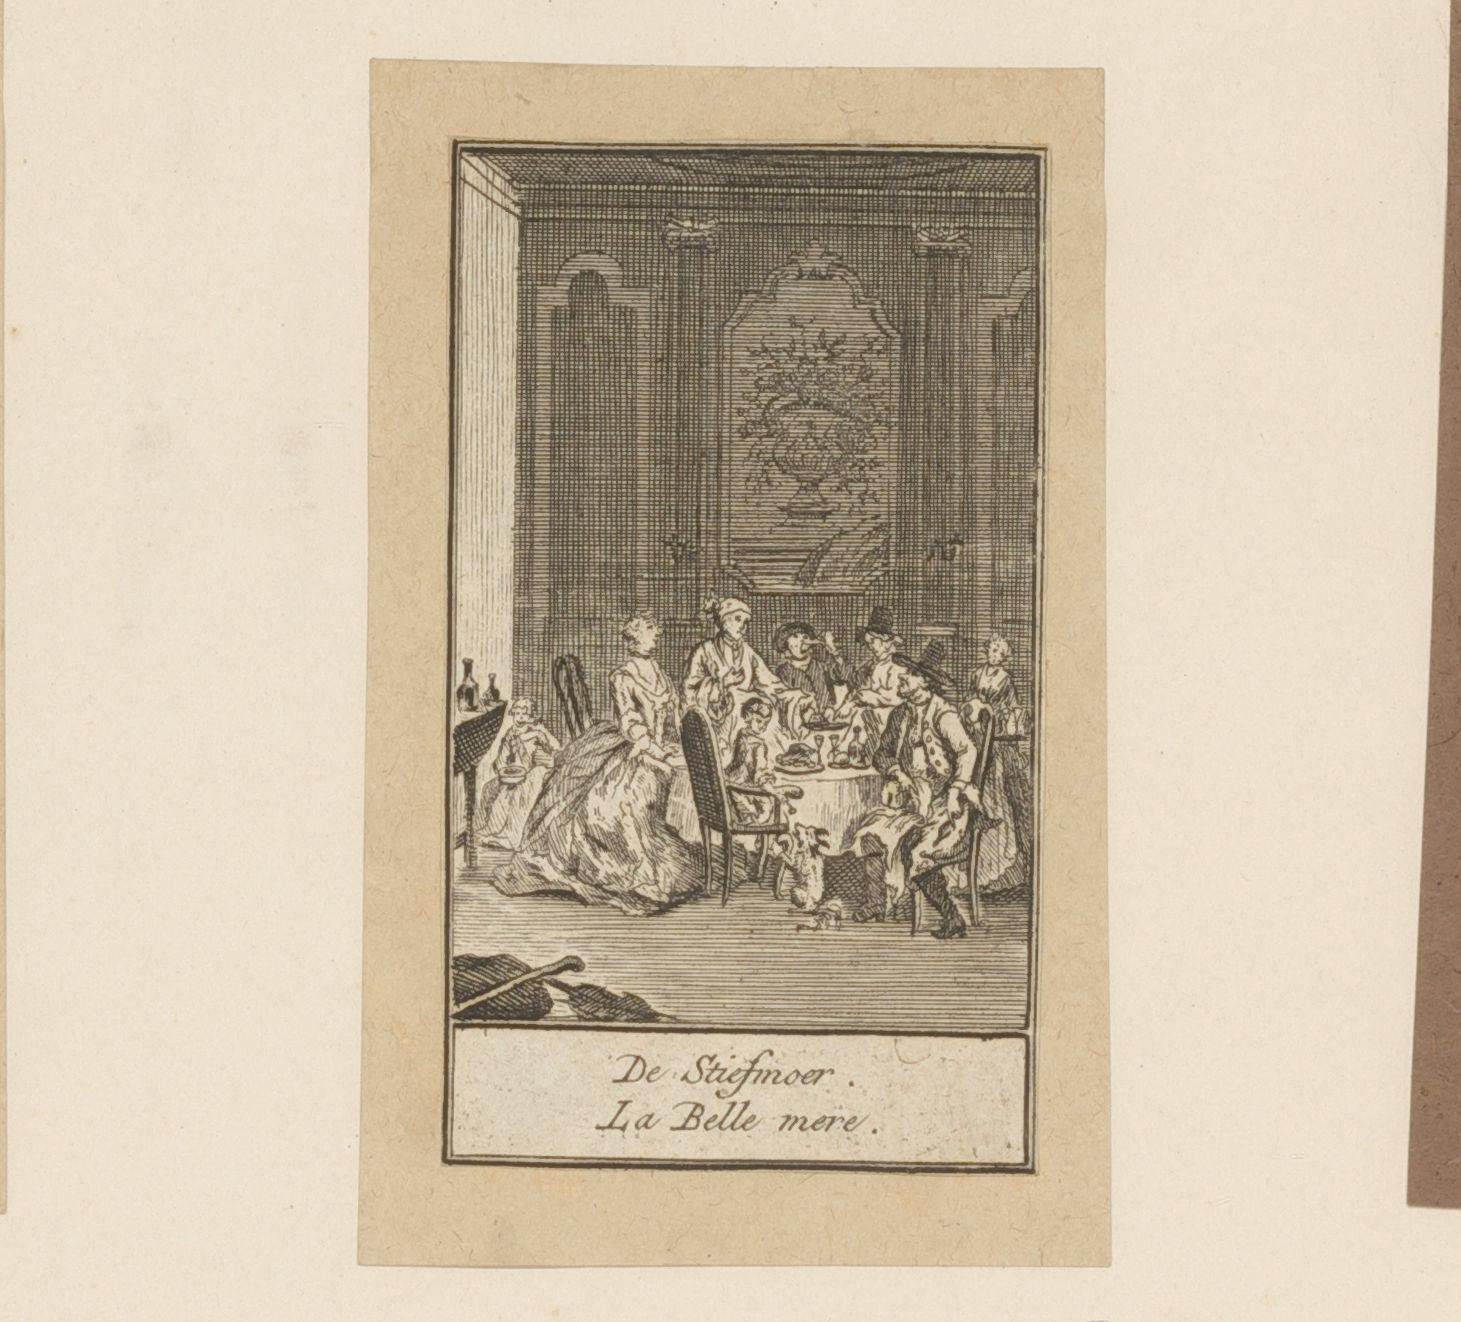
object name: print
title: De Stiefmoer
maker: Anonymous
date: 1760-1799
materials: paper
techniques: engraving, etching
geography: netherlands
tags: giving food, contrast between rich and poor, eating and drinking, dining-room, comedy, dog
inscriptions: collector's mark: Lugt 2488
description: Een eetkamer met figuren rond een tafel waaraan een staande heer een bord reikt aan zijn gasten. Rechts een rijk aangeklede vrouw en kind. Tegenover hen drie sober geklede heren. Rechts op de achtergrond een kind dat uit een pan eet. Op de voorgrond een kind aan tafel dat een hond een stuk vlees geeft. Links een bediende met glazen. Scène uit het blijspel De Stiefmoêr van Thomas Asselyn uit 1684, waarin het personage Jochem de arme familie van zijn tweede vrouw op bezoek krijgt. Uit een serie van tien verkleinde latere kopieën, waarschijnlijk uit een almanak.